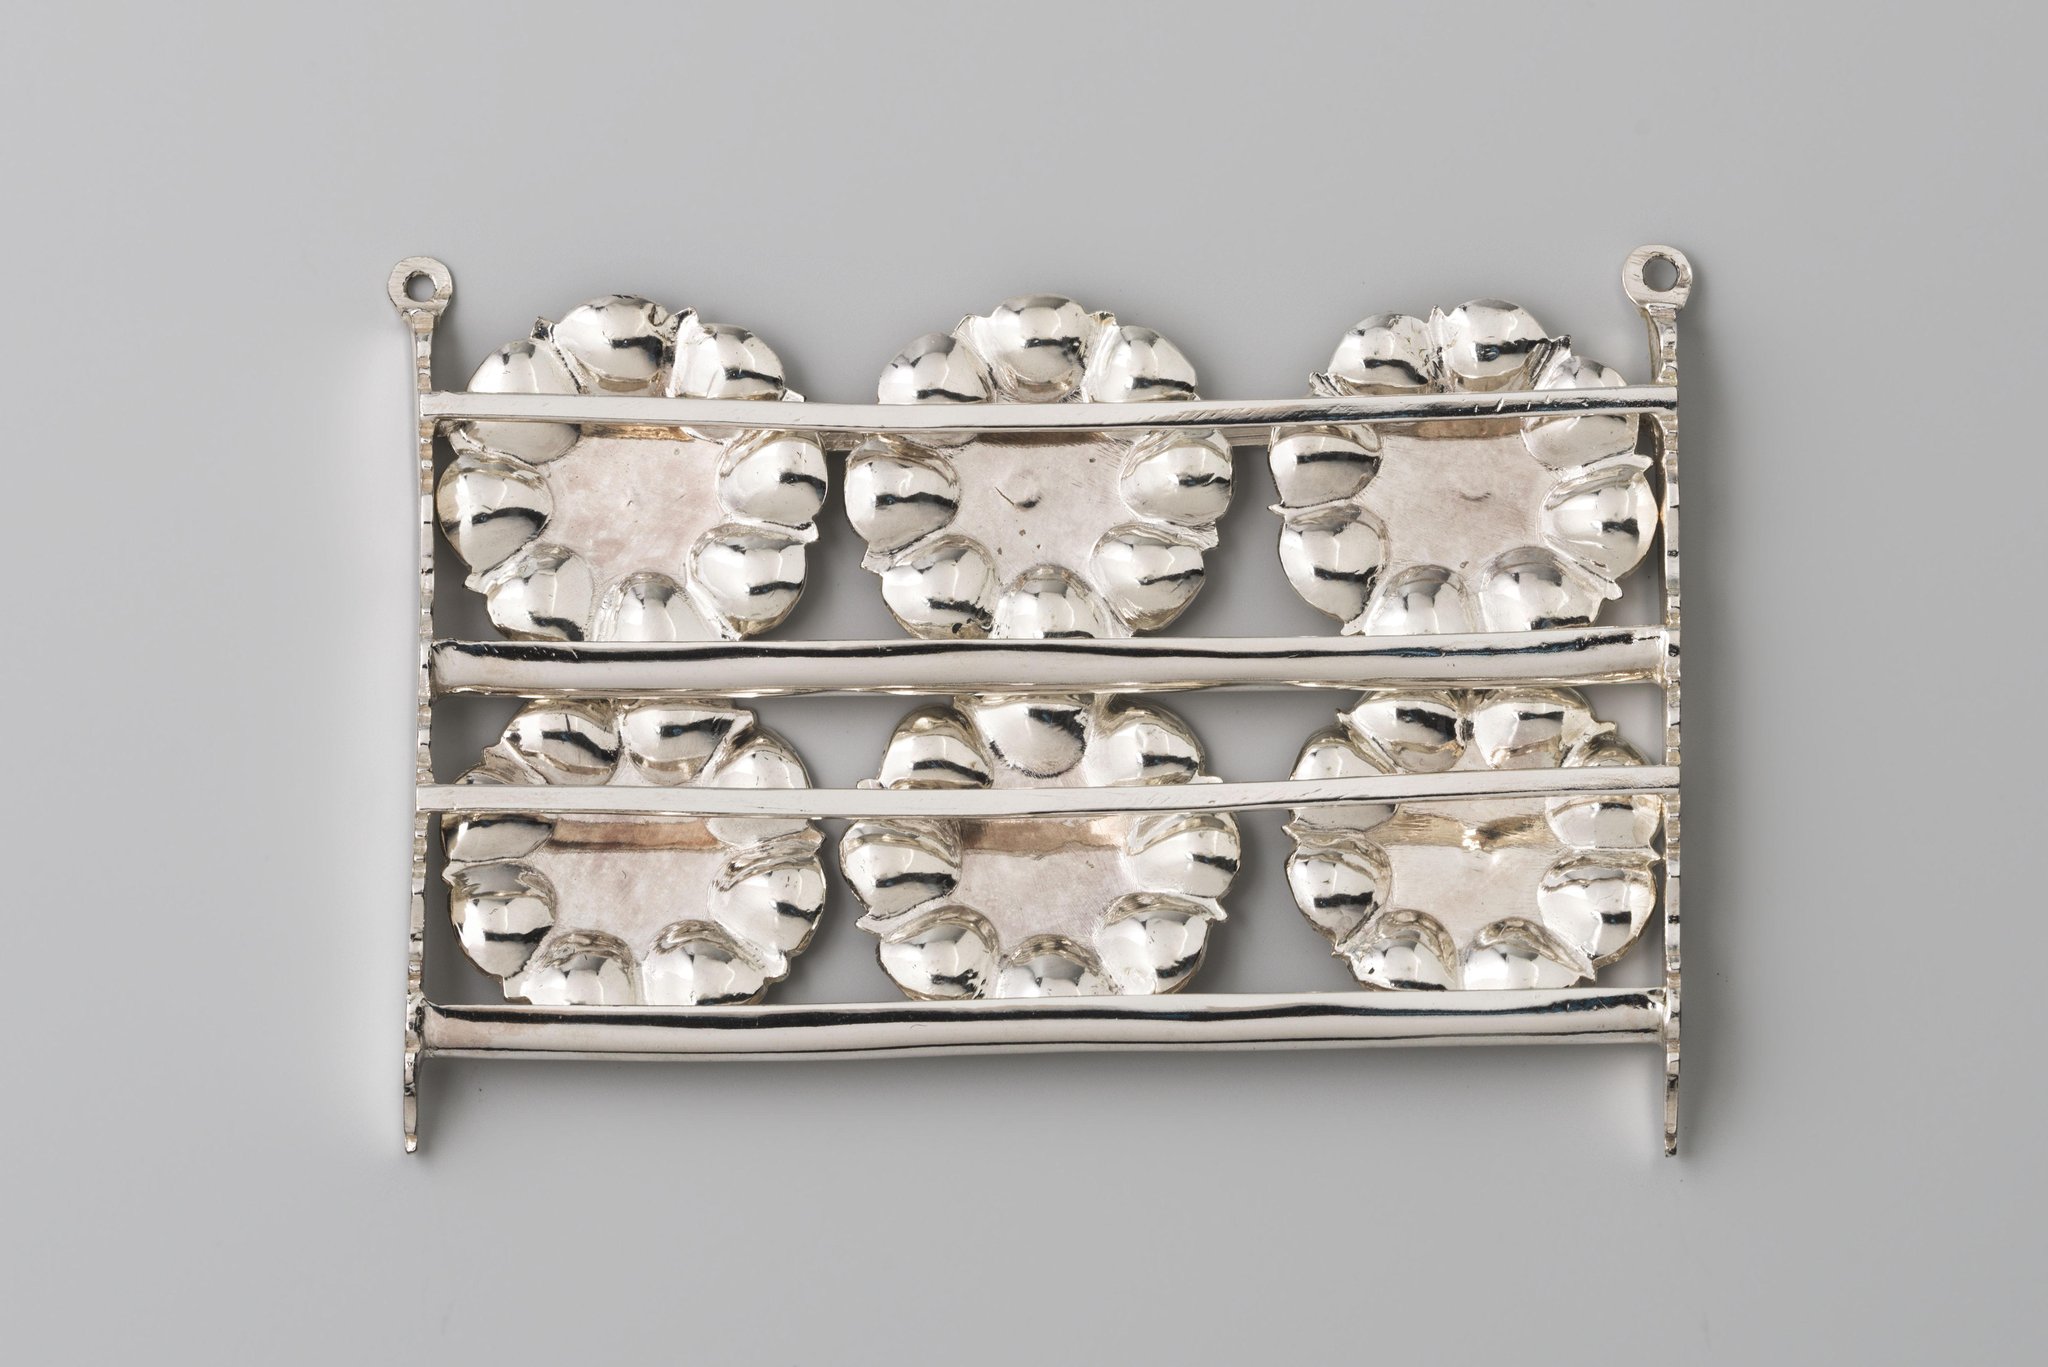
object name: miniature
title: Schotelrek met zes plooischotels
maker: Anonymous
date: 1675-1725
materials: silver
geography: amsterdam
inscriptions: maker's mark: ‘kop of vuist in rond (Voet 1912, nr. 373; Citroen 1975, nr. 970?)’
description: Schotelrek van zilver, glad met geprofileerde zijwangen, met hangogen, twee lagen (A). Hierop zes plooischotels (B t/m G) van zilver met acht lobben.